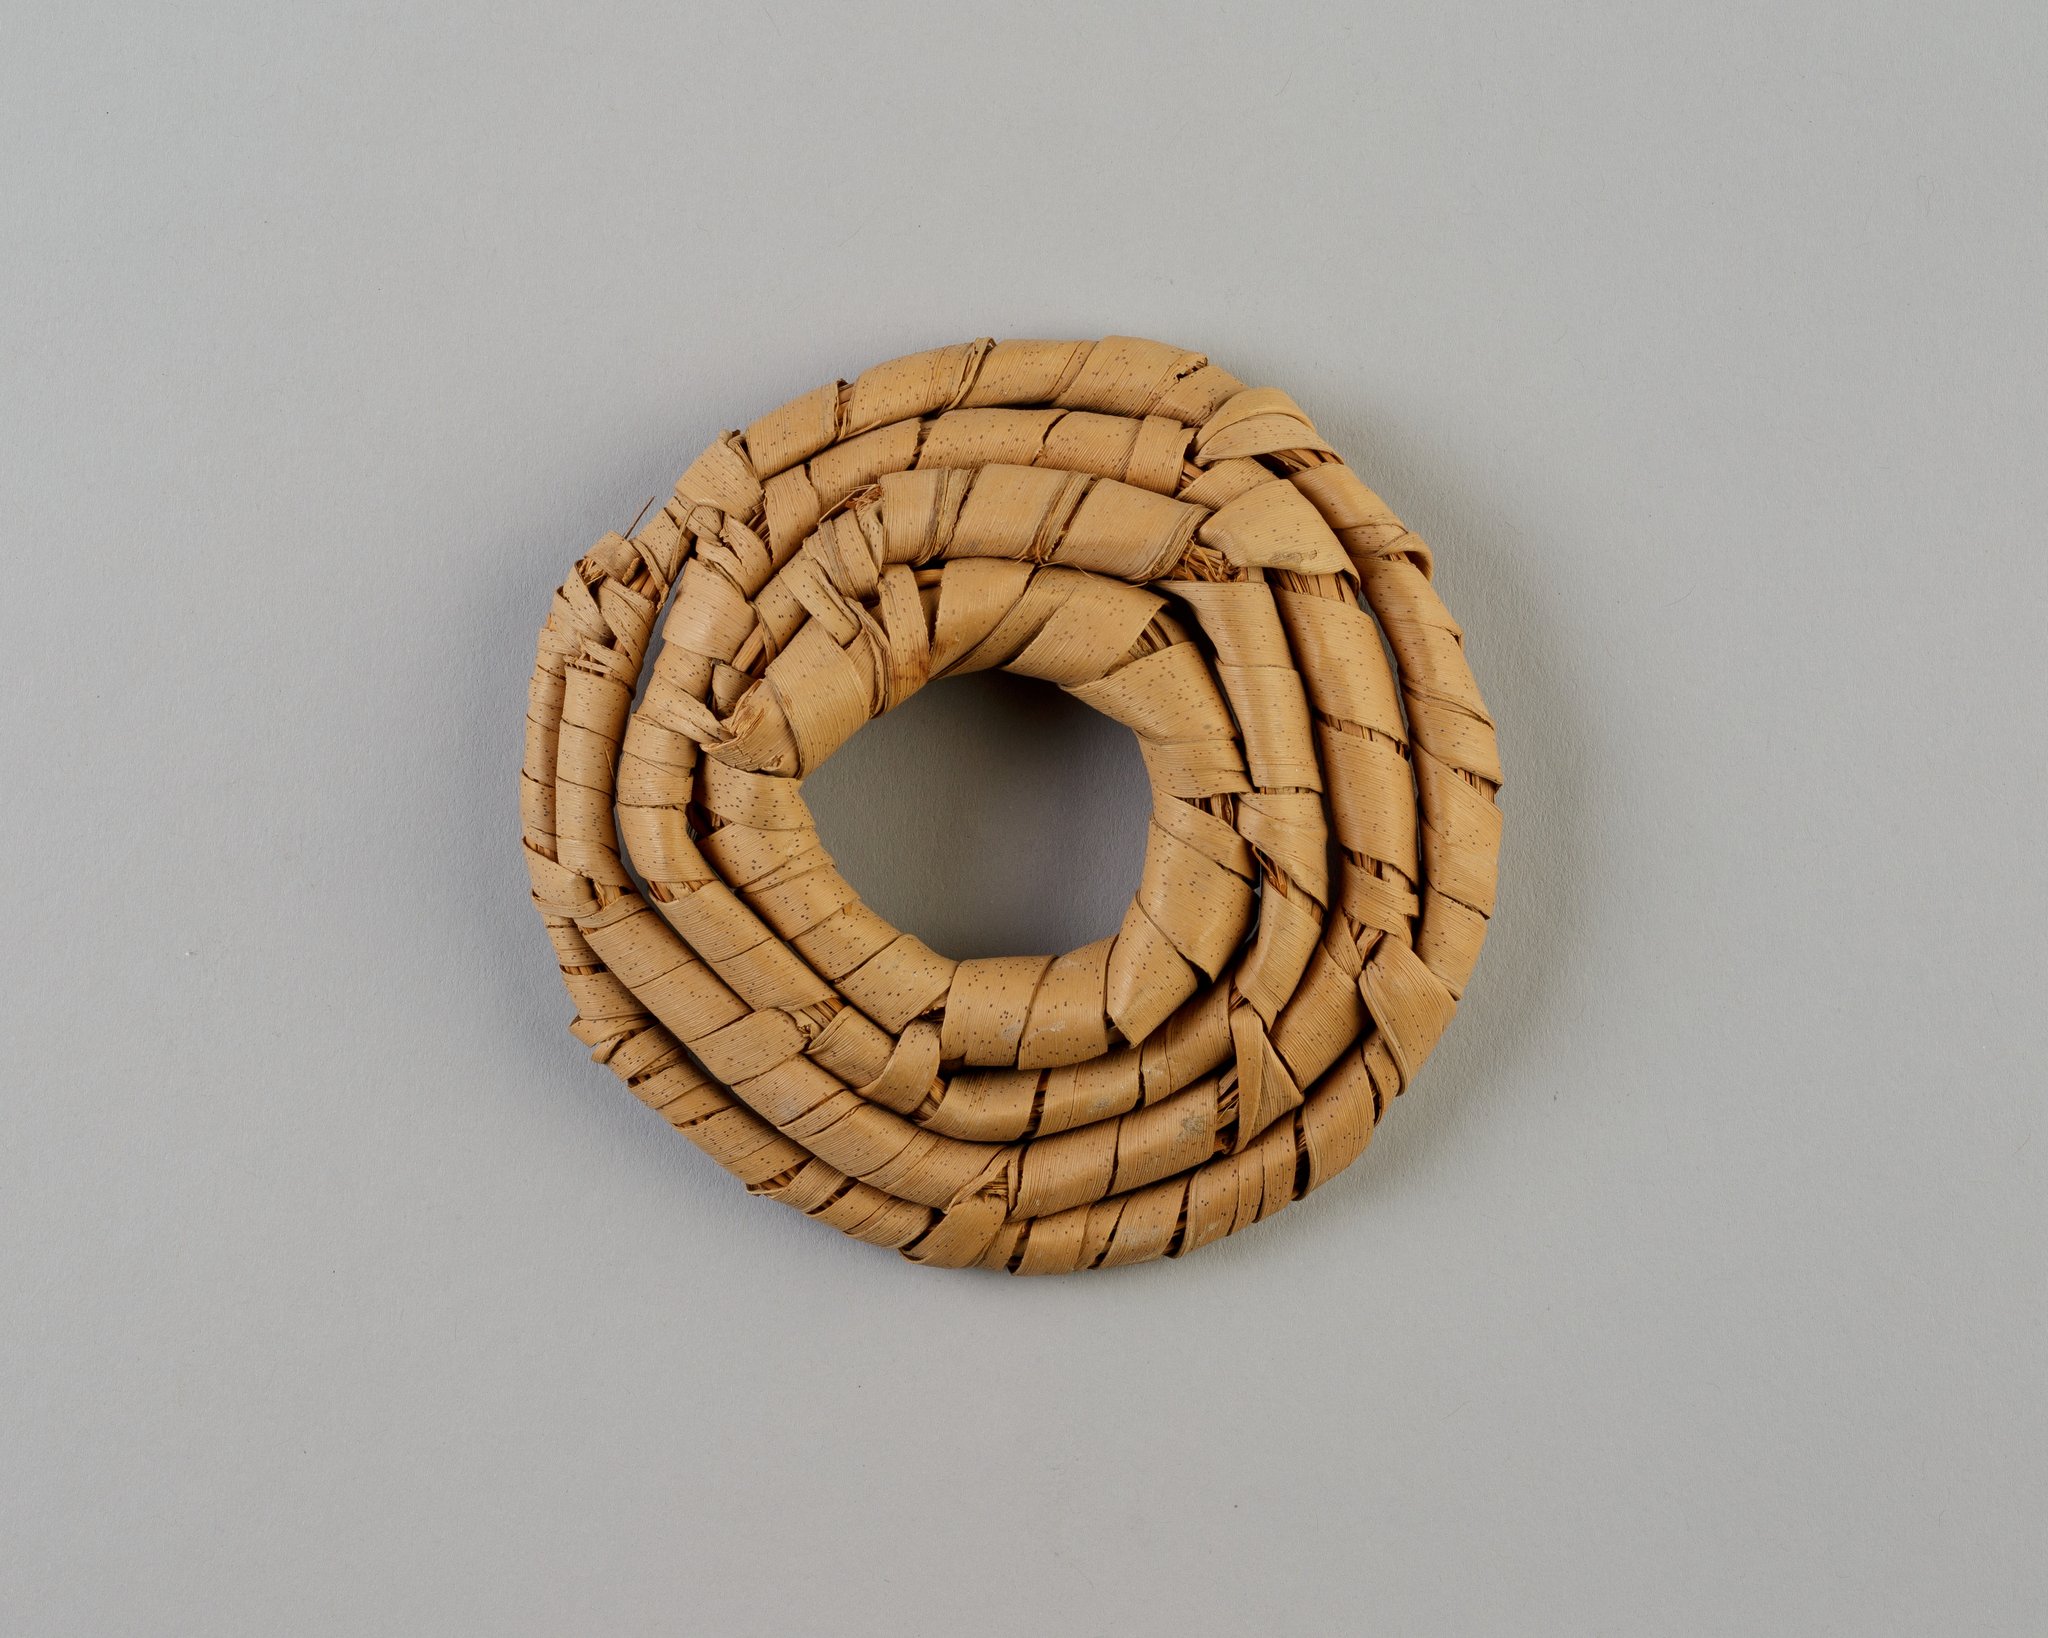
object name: basketry, model, senenmut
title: Pot Stand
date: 1479-1458 BCE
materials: leaf, fiber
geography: egypt